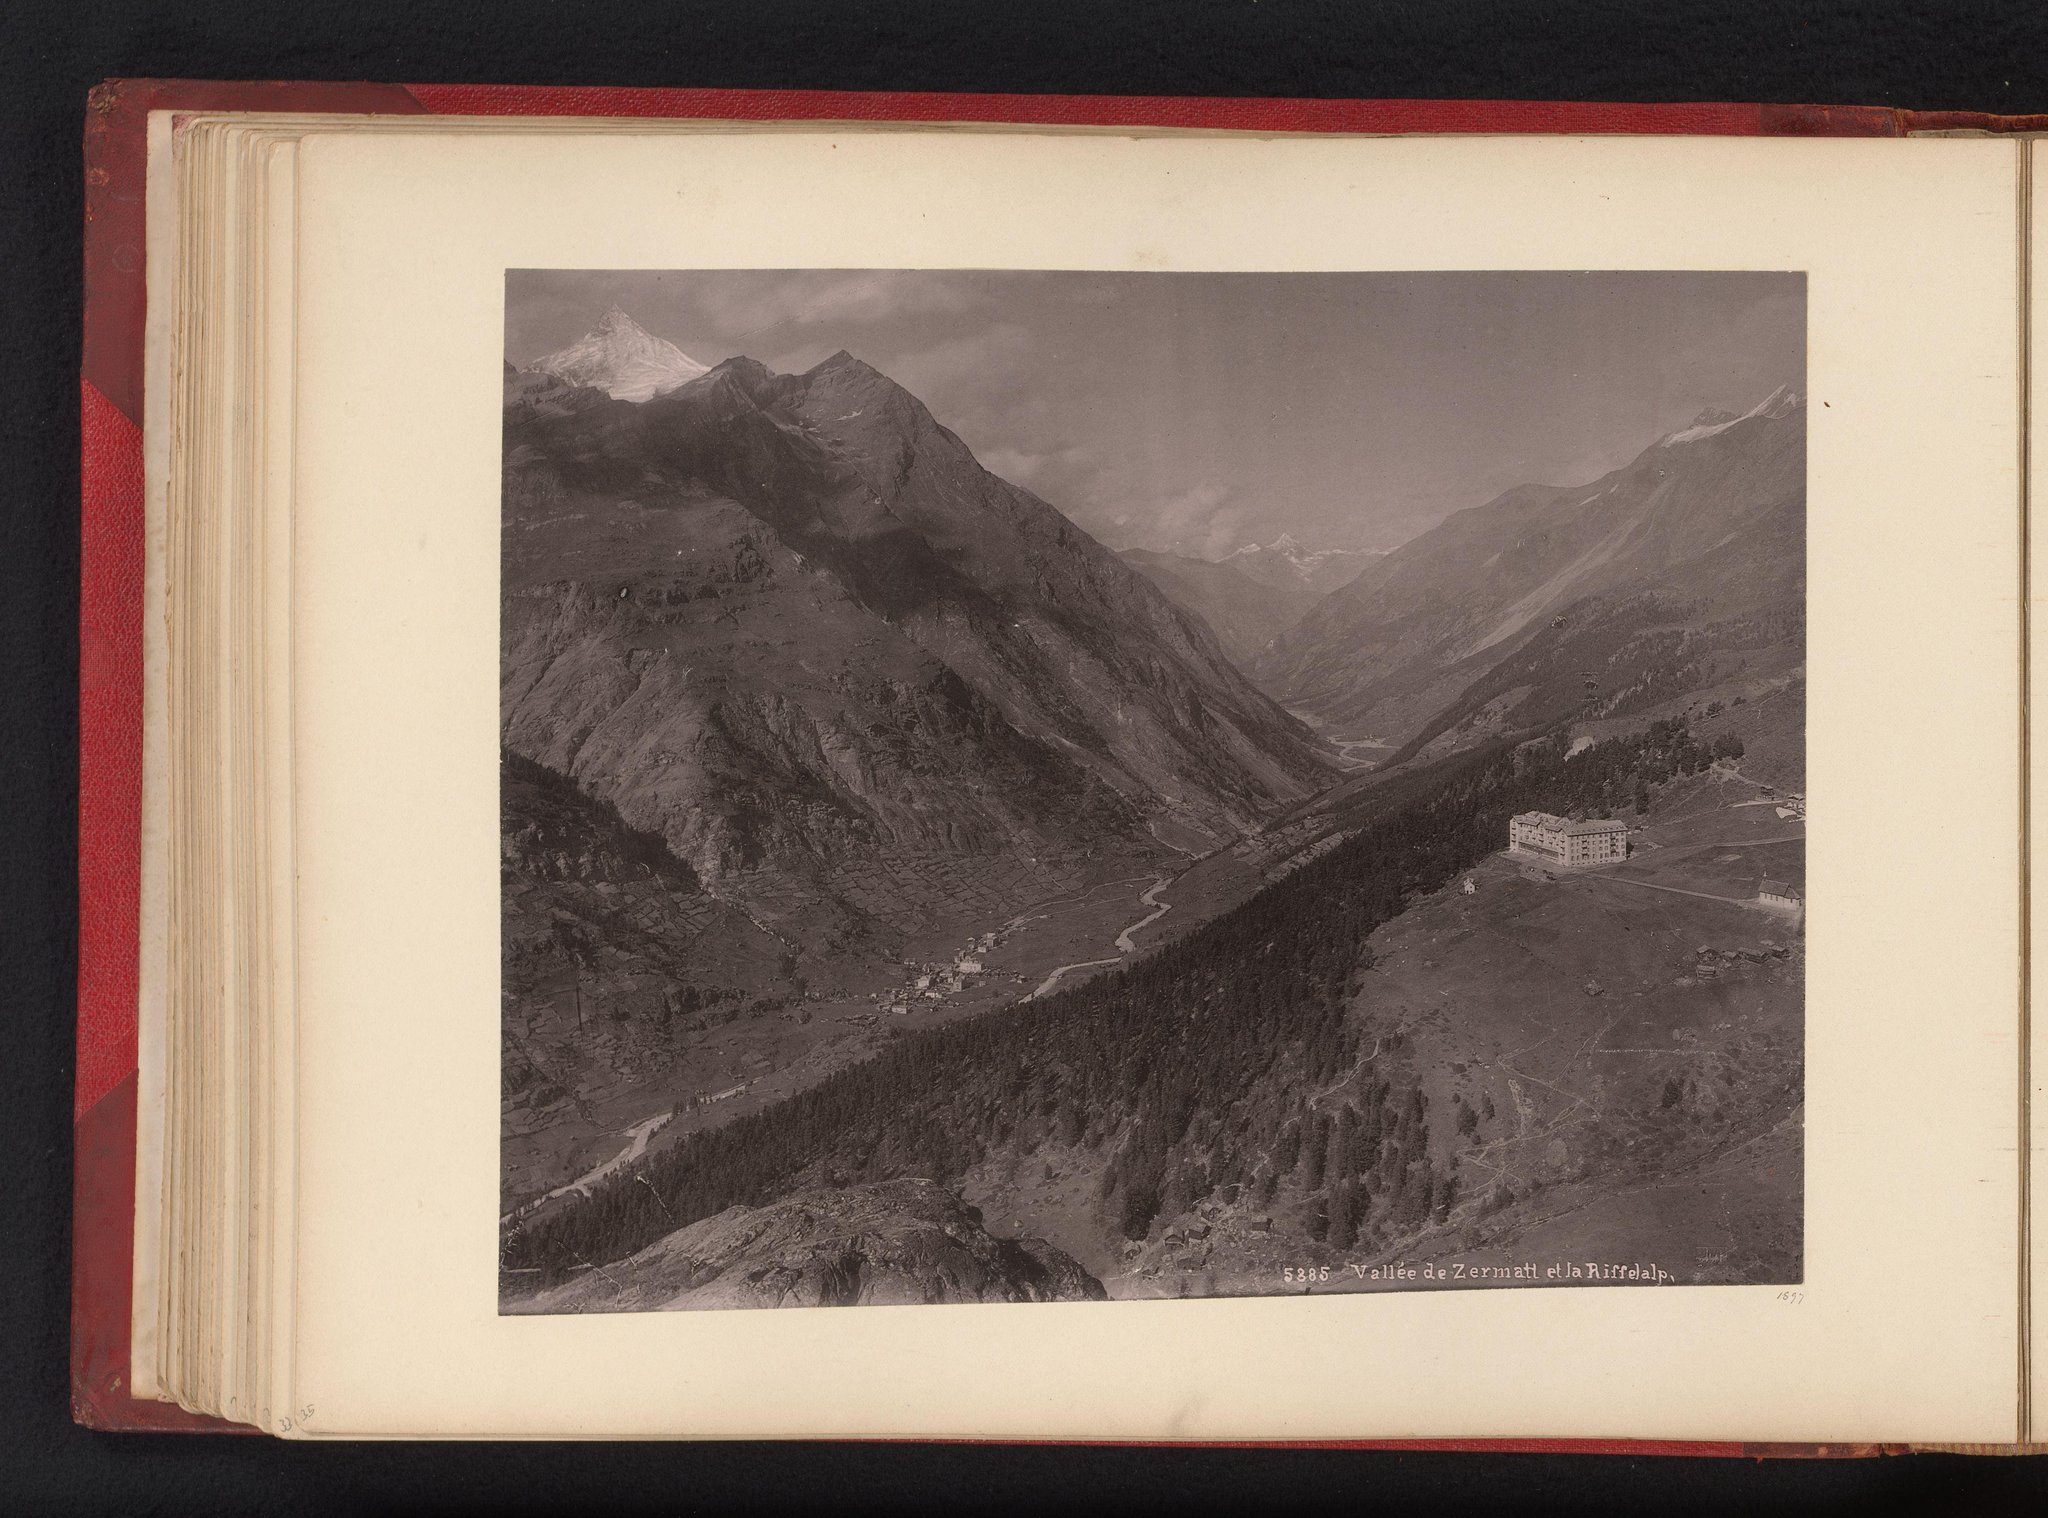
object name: album leaf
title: Gezicht op de vallei bij Zermatt met de Riffelalp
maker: Anonymous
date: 1897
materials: paper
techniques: photograph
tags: dale, valley, mountain-range, snow peaks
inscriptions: annotation: ‘1897’, inscription: ‘5385 Vallée de Zermatt et la Riffelalp’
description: Deze prent maakt deel uit van een album.